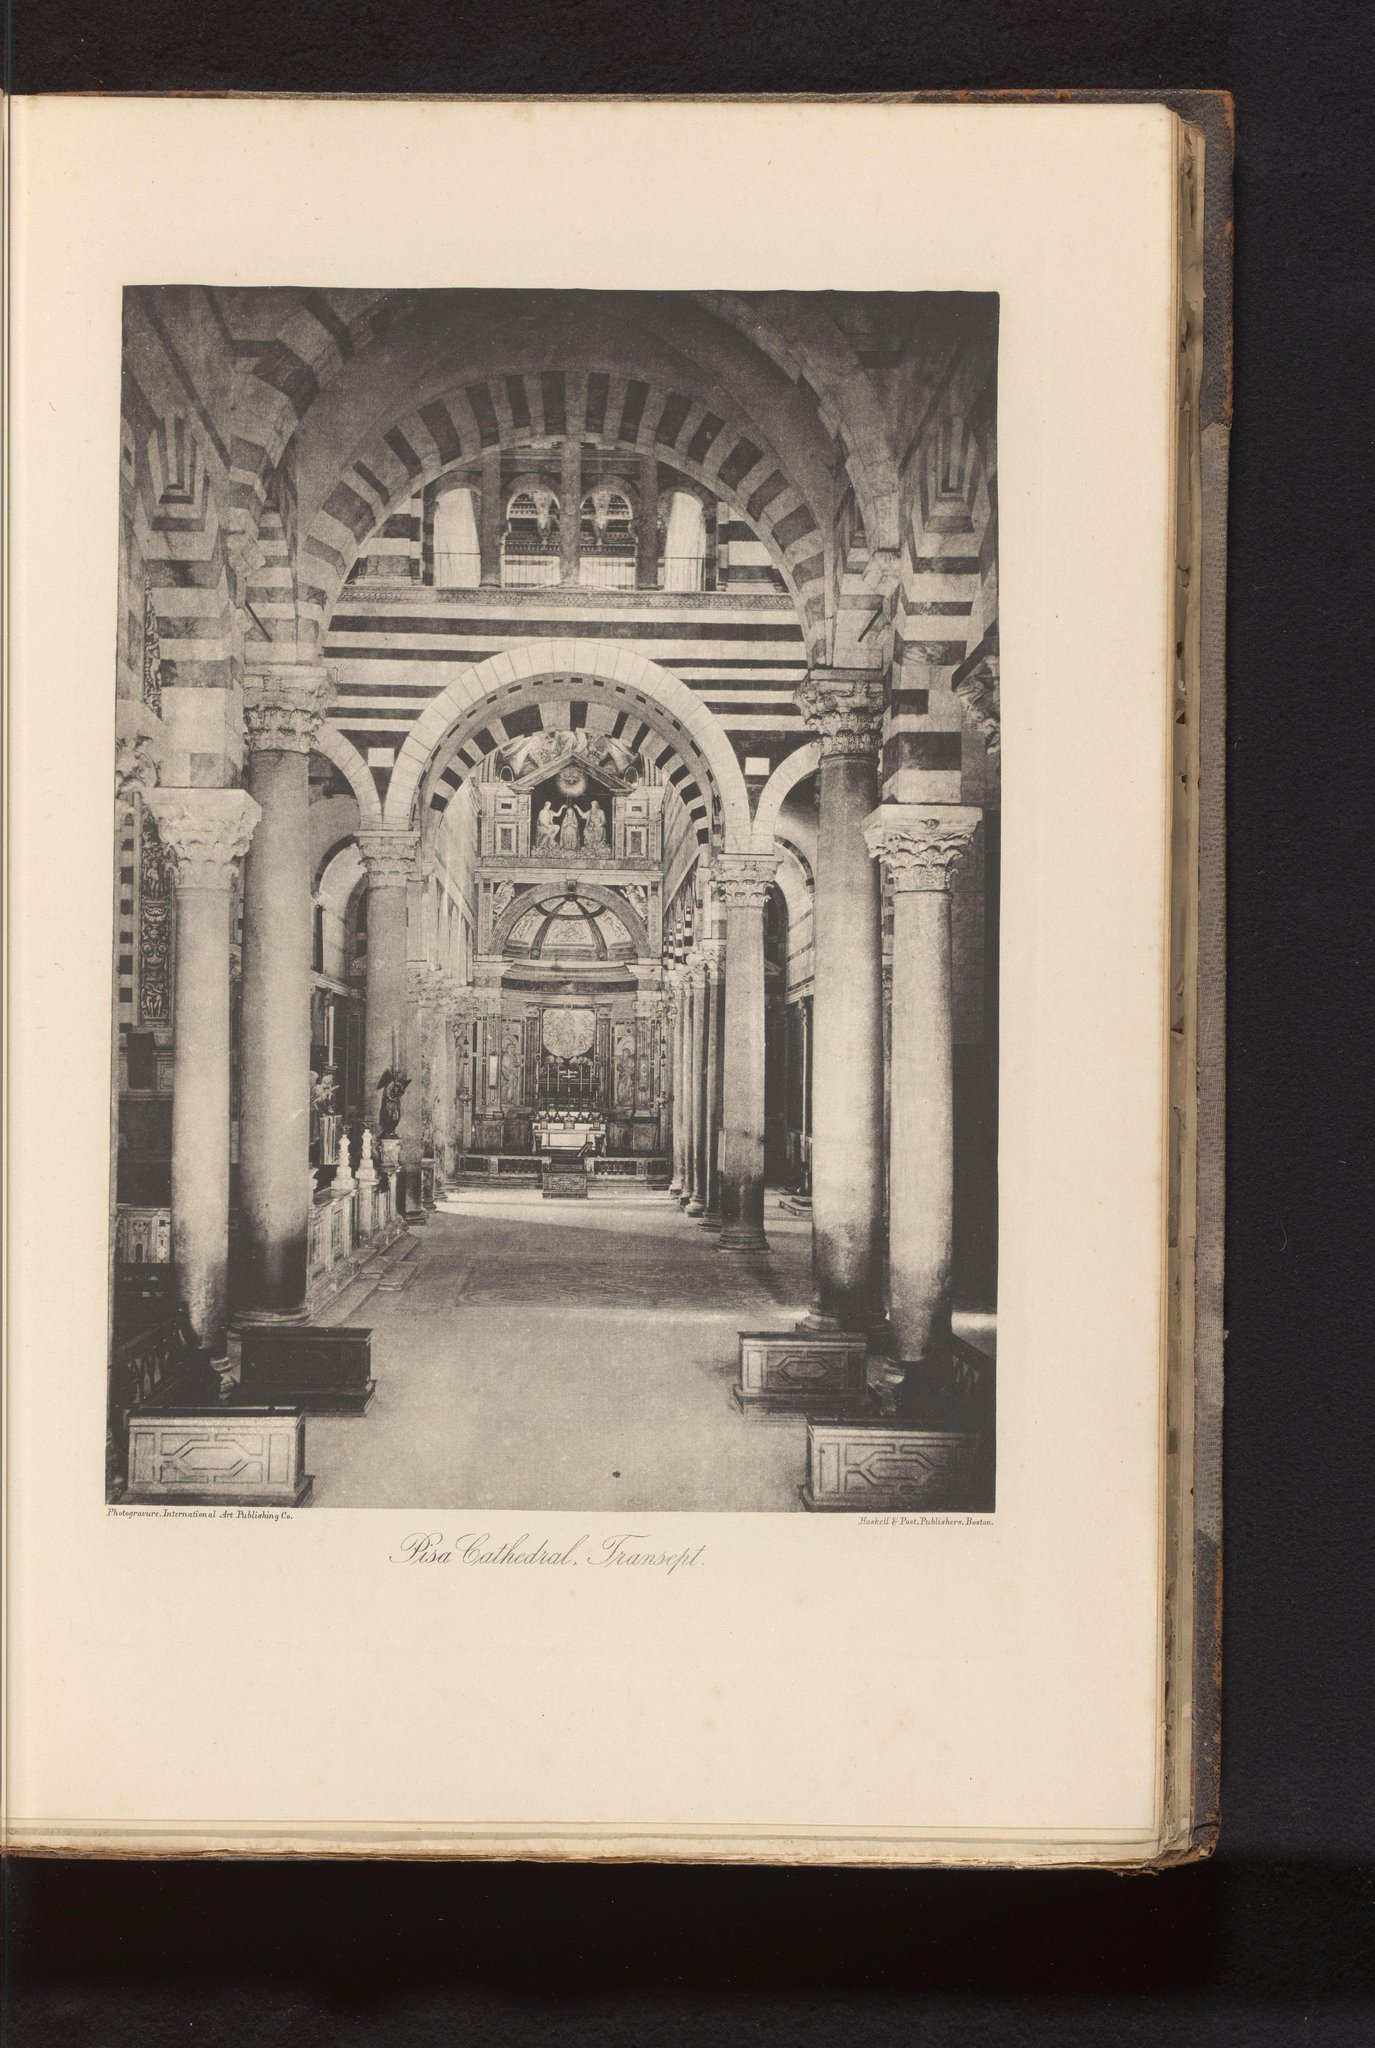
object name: page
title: Pisa Cathedral, Transept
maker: Anonymous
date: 1881-1886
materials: paper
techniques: photograph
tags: parts of church interior: transept